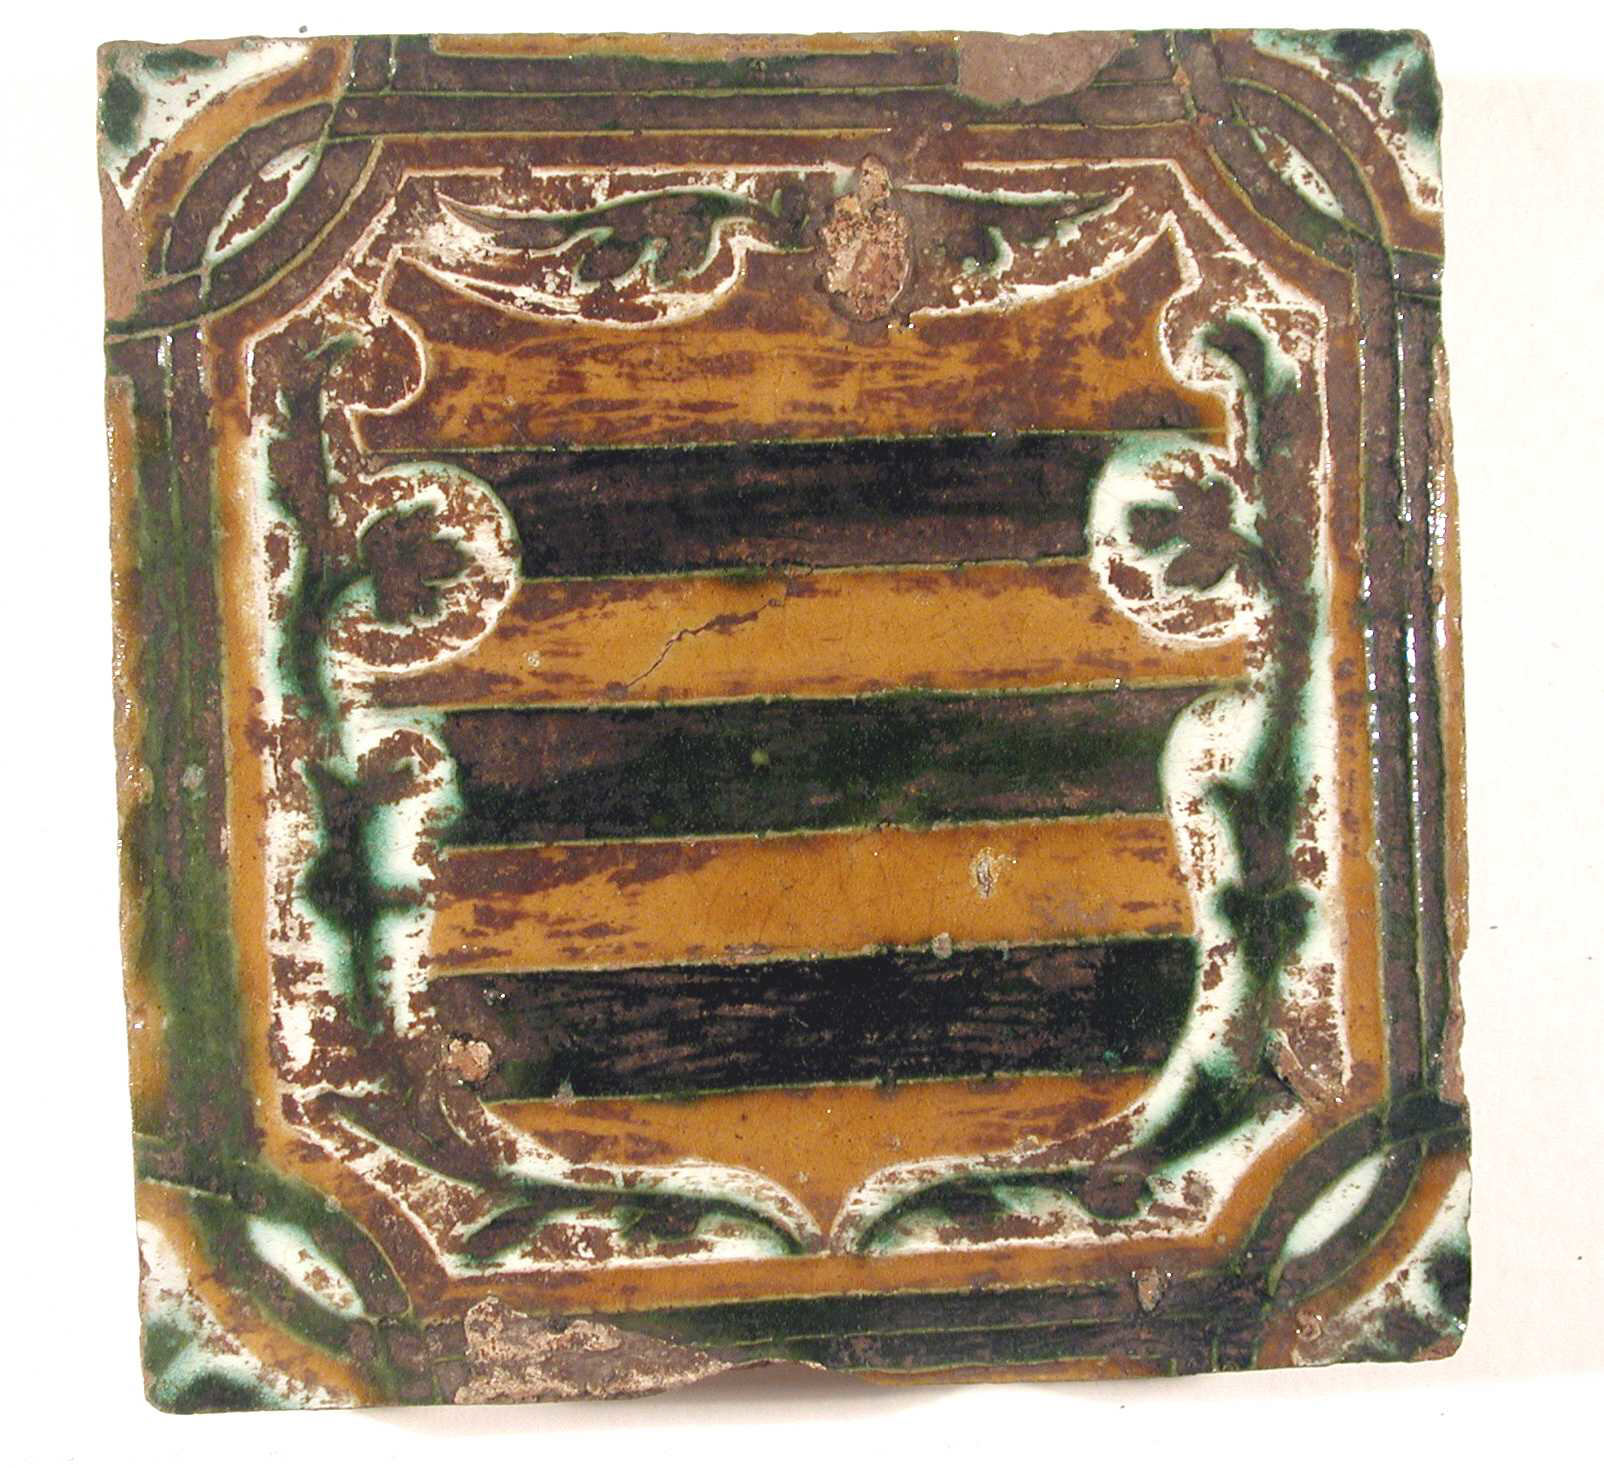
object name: wall tile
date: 1501-1600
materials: earthenware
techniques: luster painting, glazing